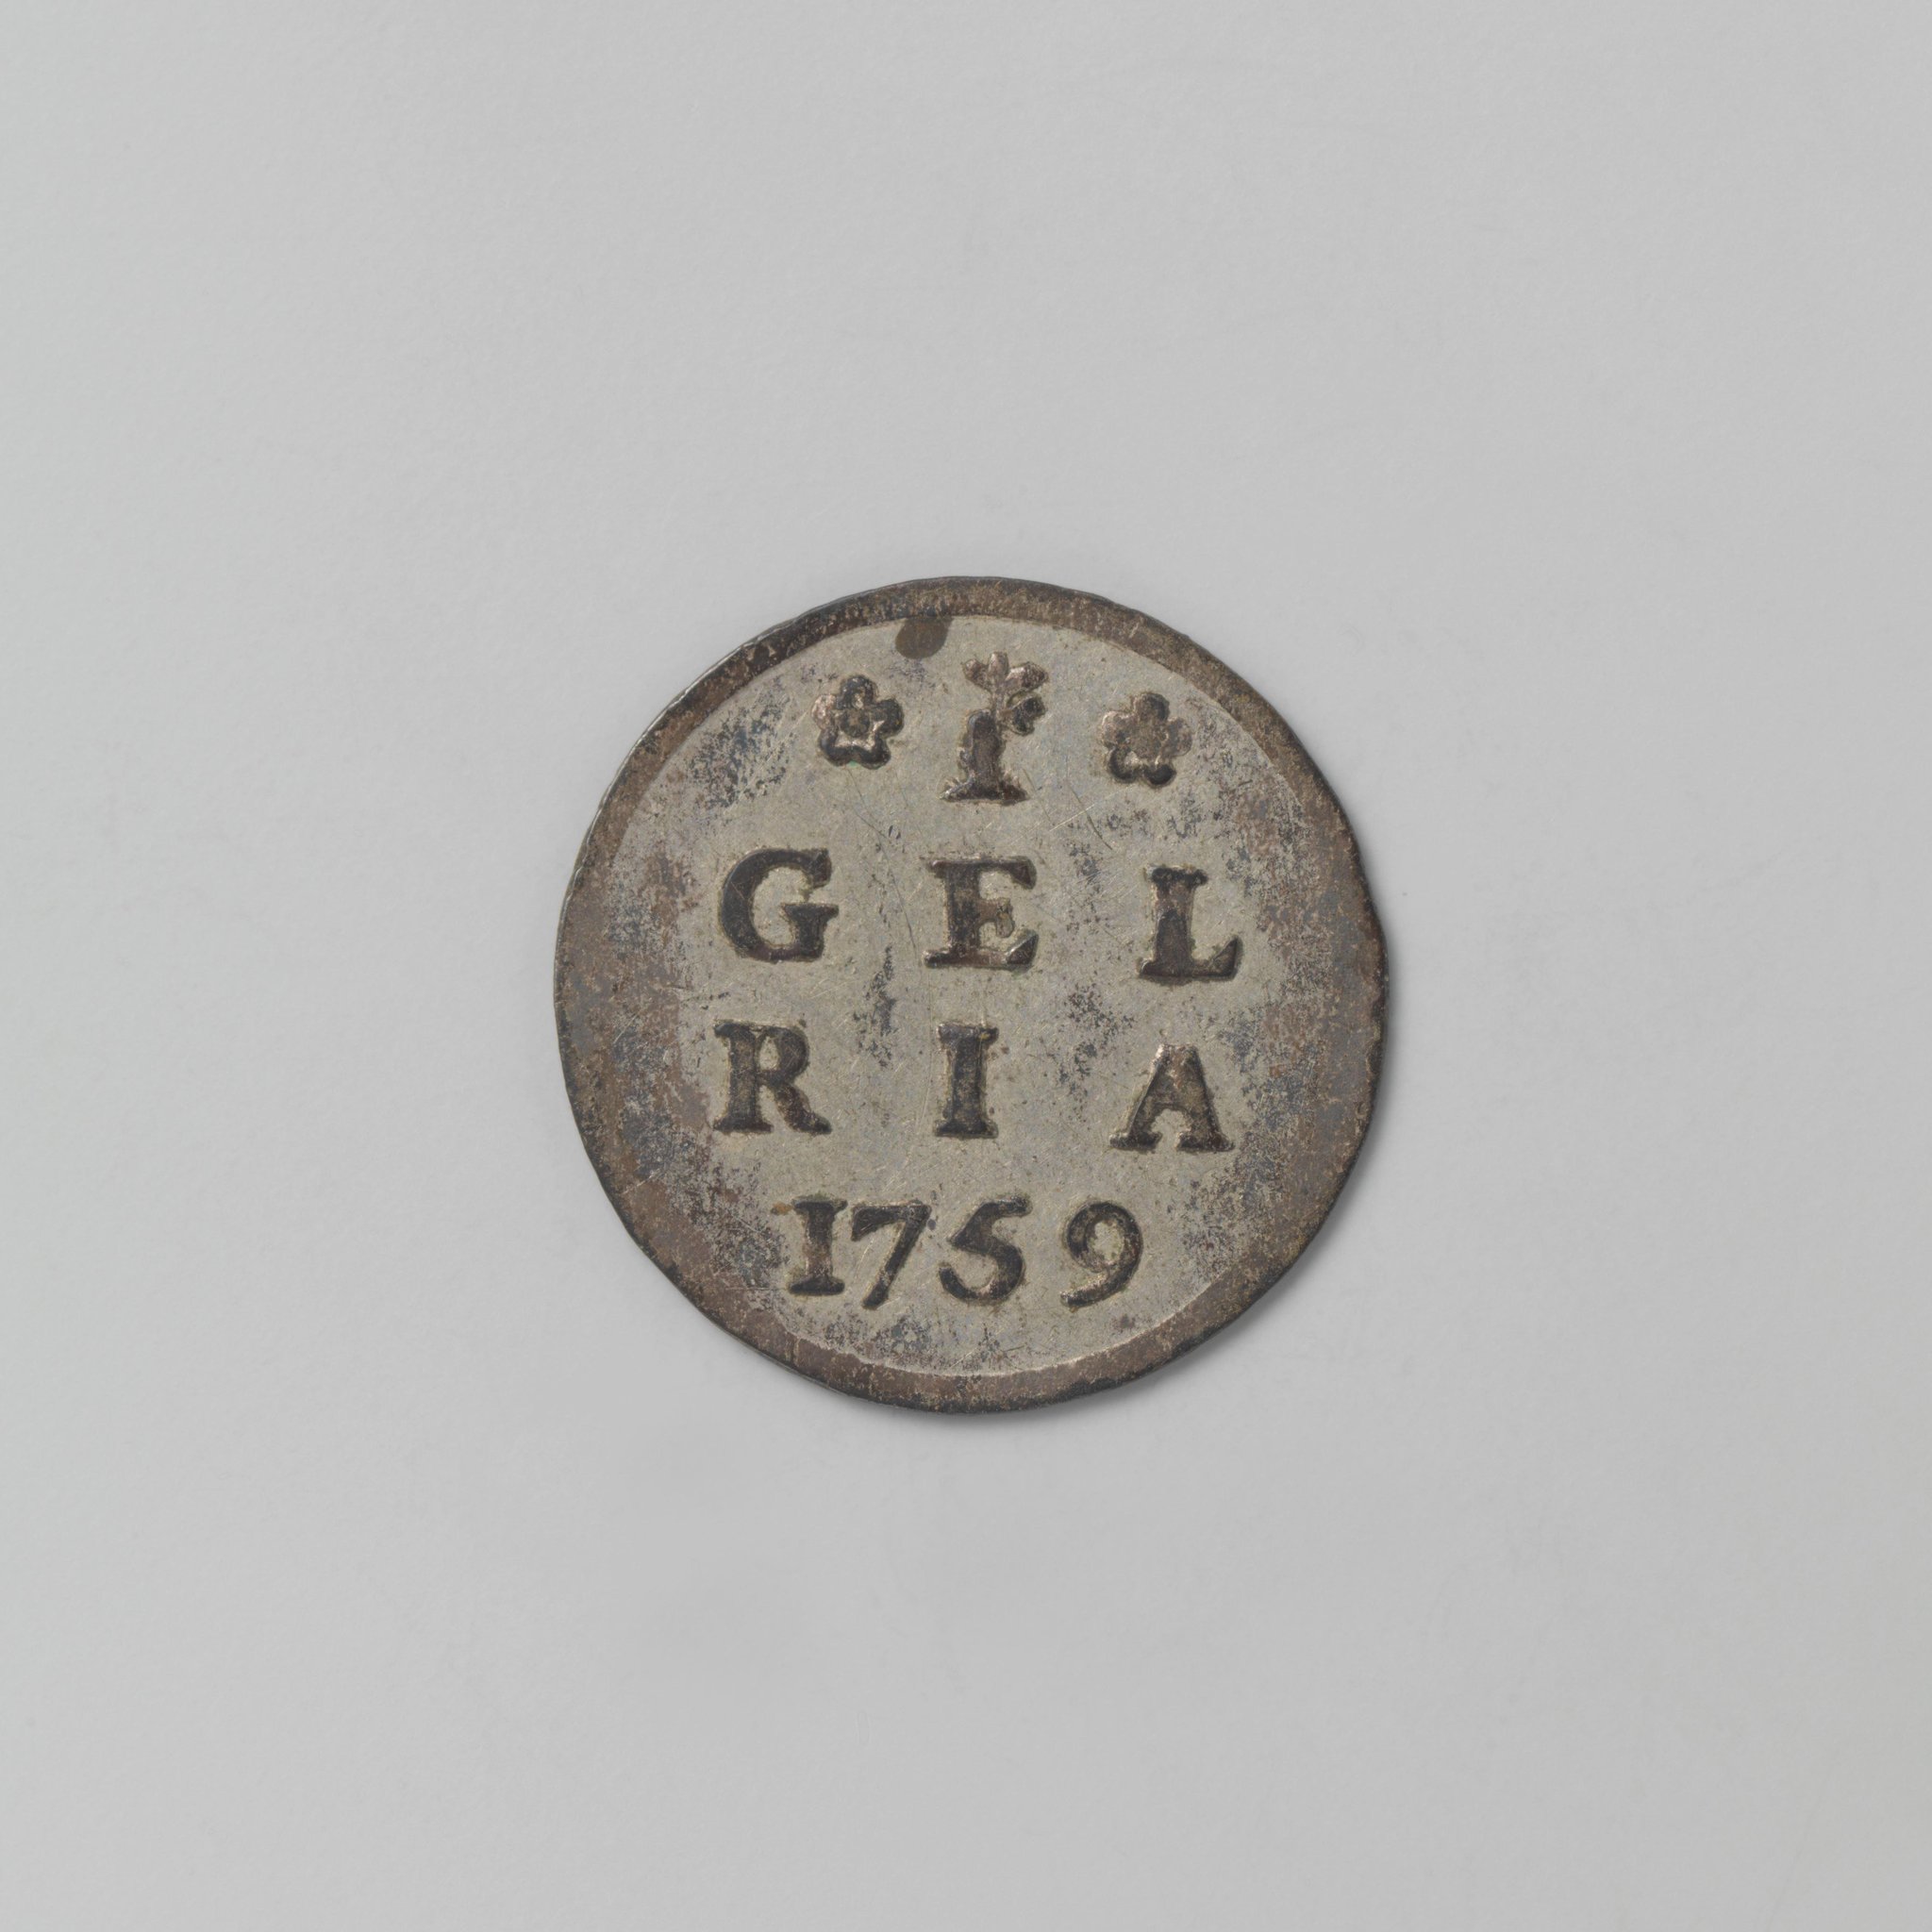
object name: coin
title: Gelderse stuiver, 1759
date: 1756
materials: silver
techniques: striking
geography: harderwijk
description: Zilveren munt. Voorzijde: in twee regels GEL/RIA, daaronder jaartal, daarboven muntmeesterteken. Keerzijde: binnen lauwerkrans tussen waarde-aanduiding pijlenbundel.